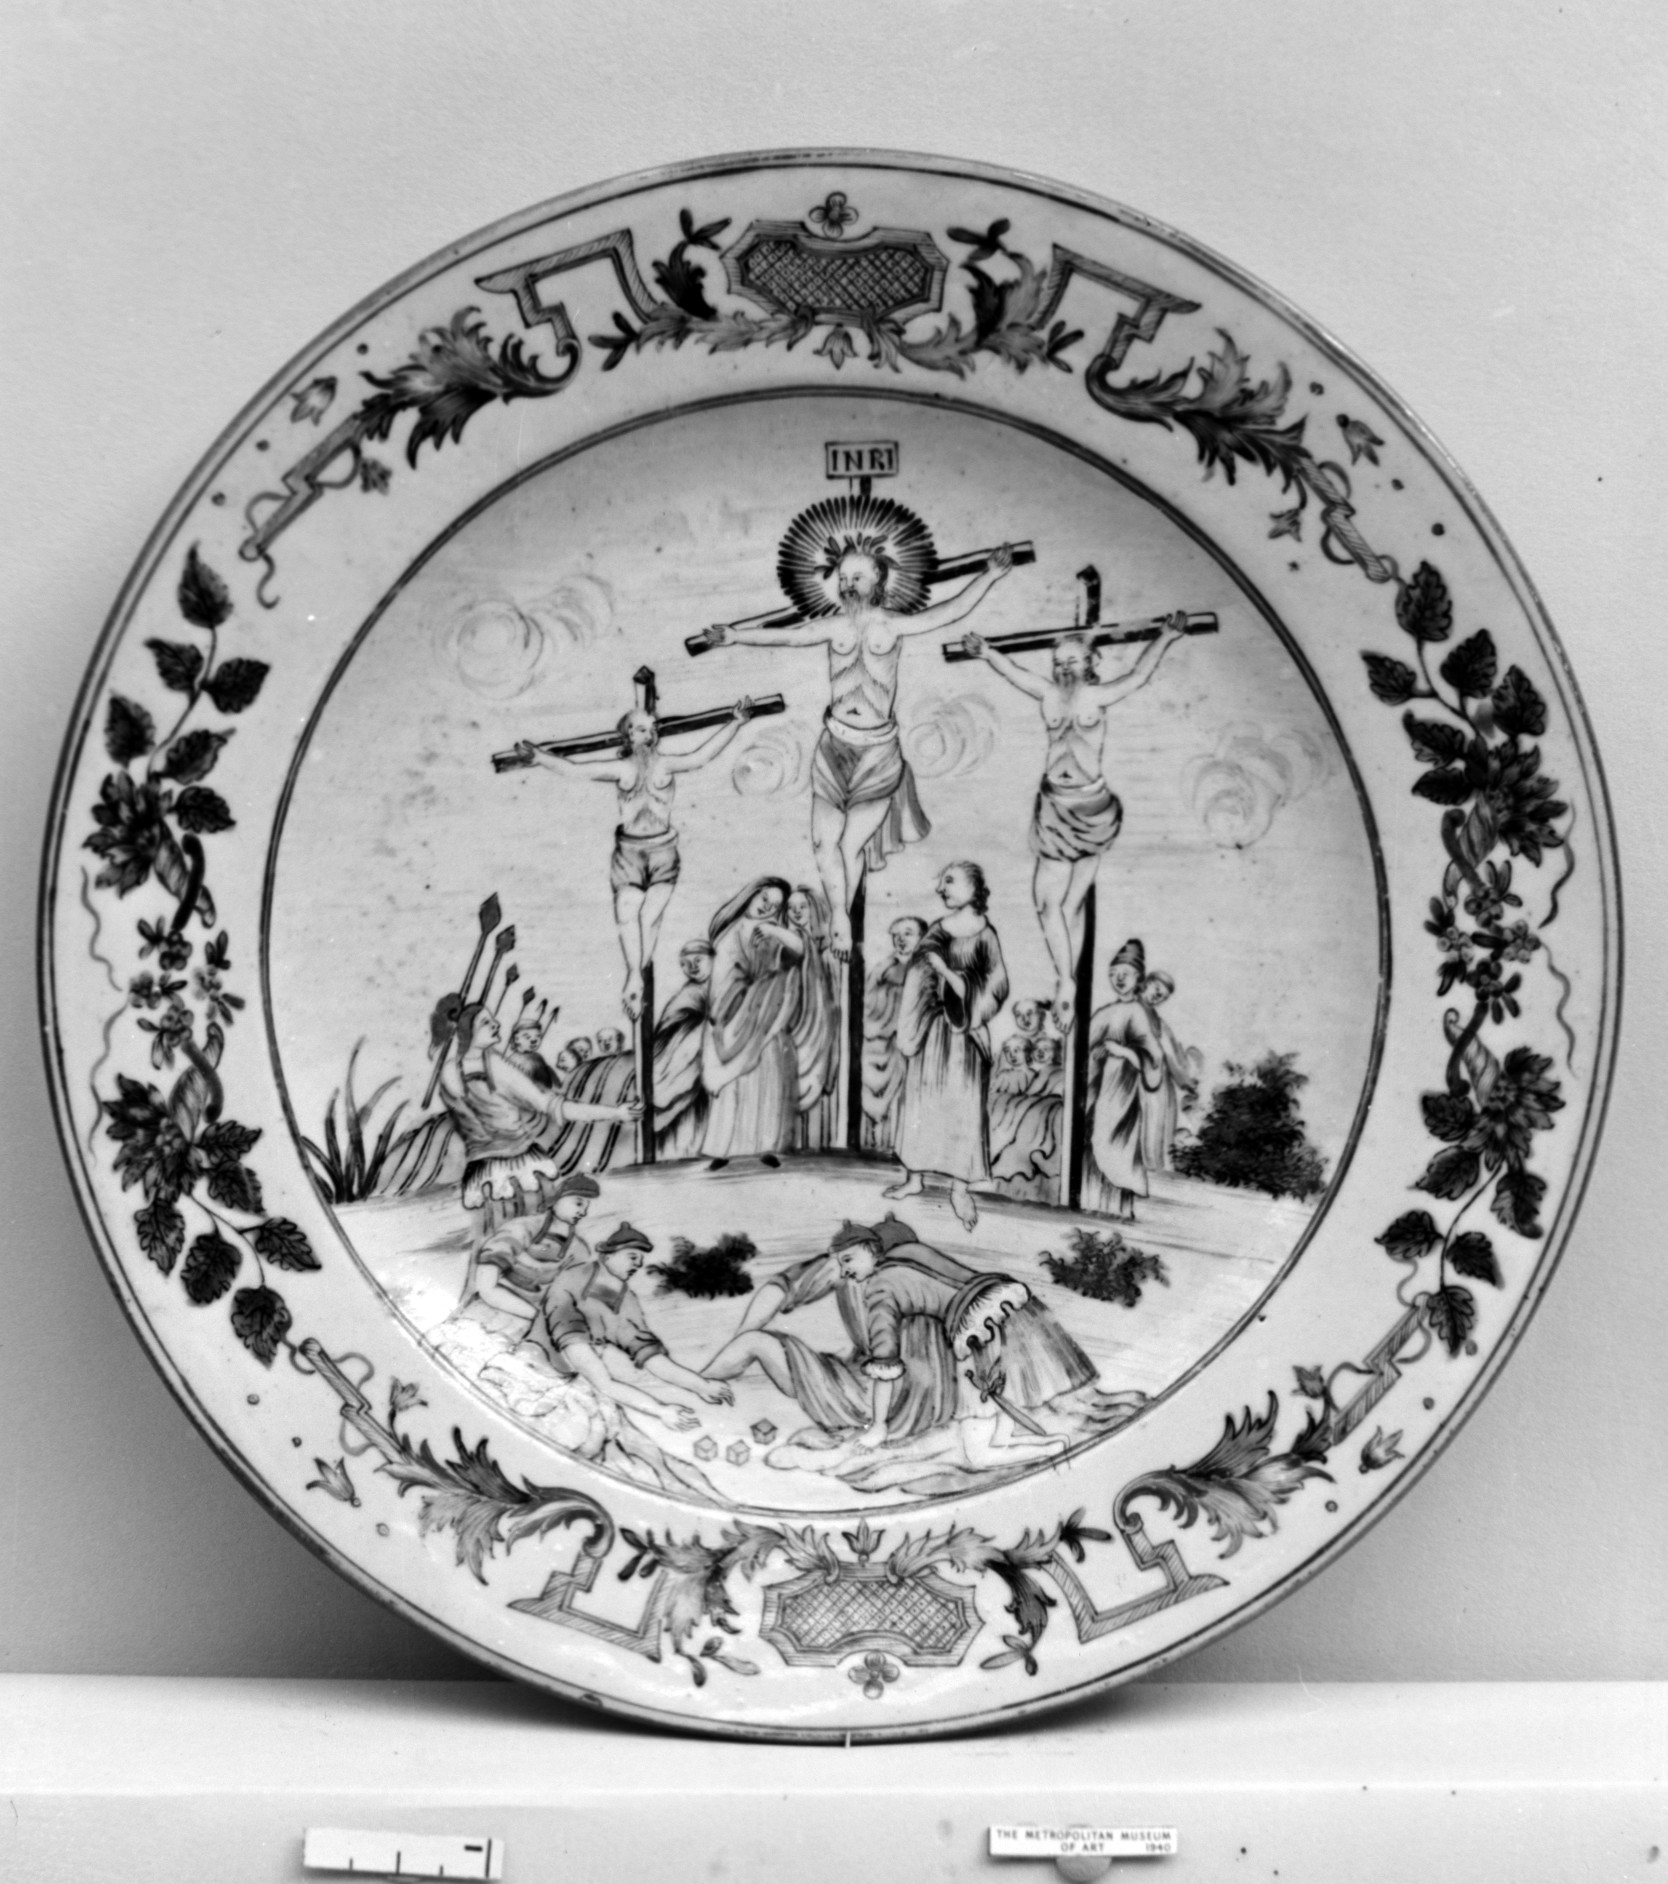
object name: plate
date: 1750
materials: hard paste porcelain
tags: crucifixion